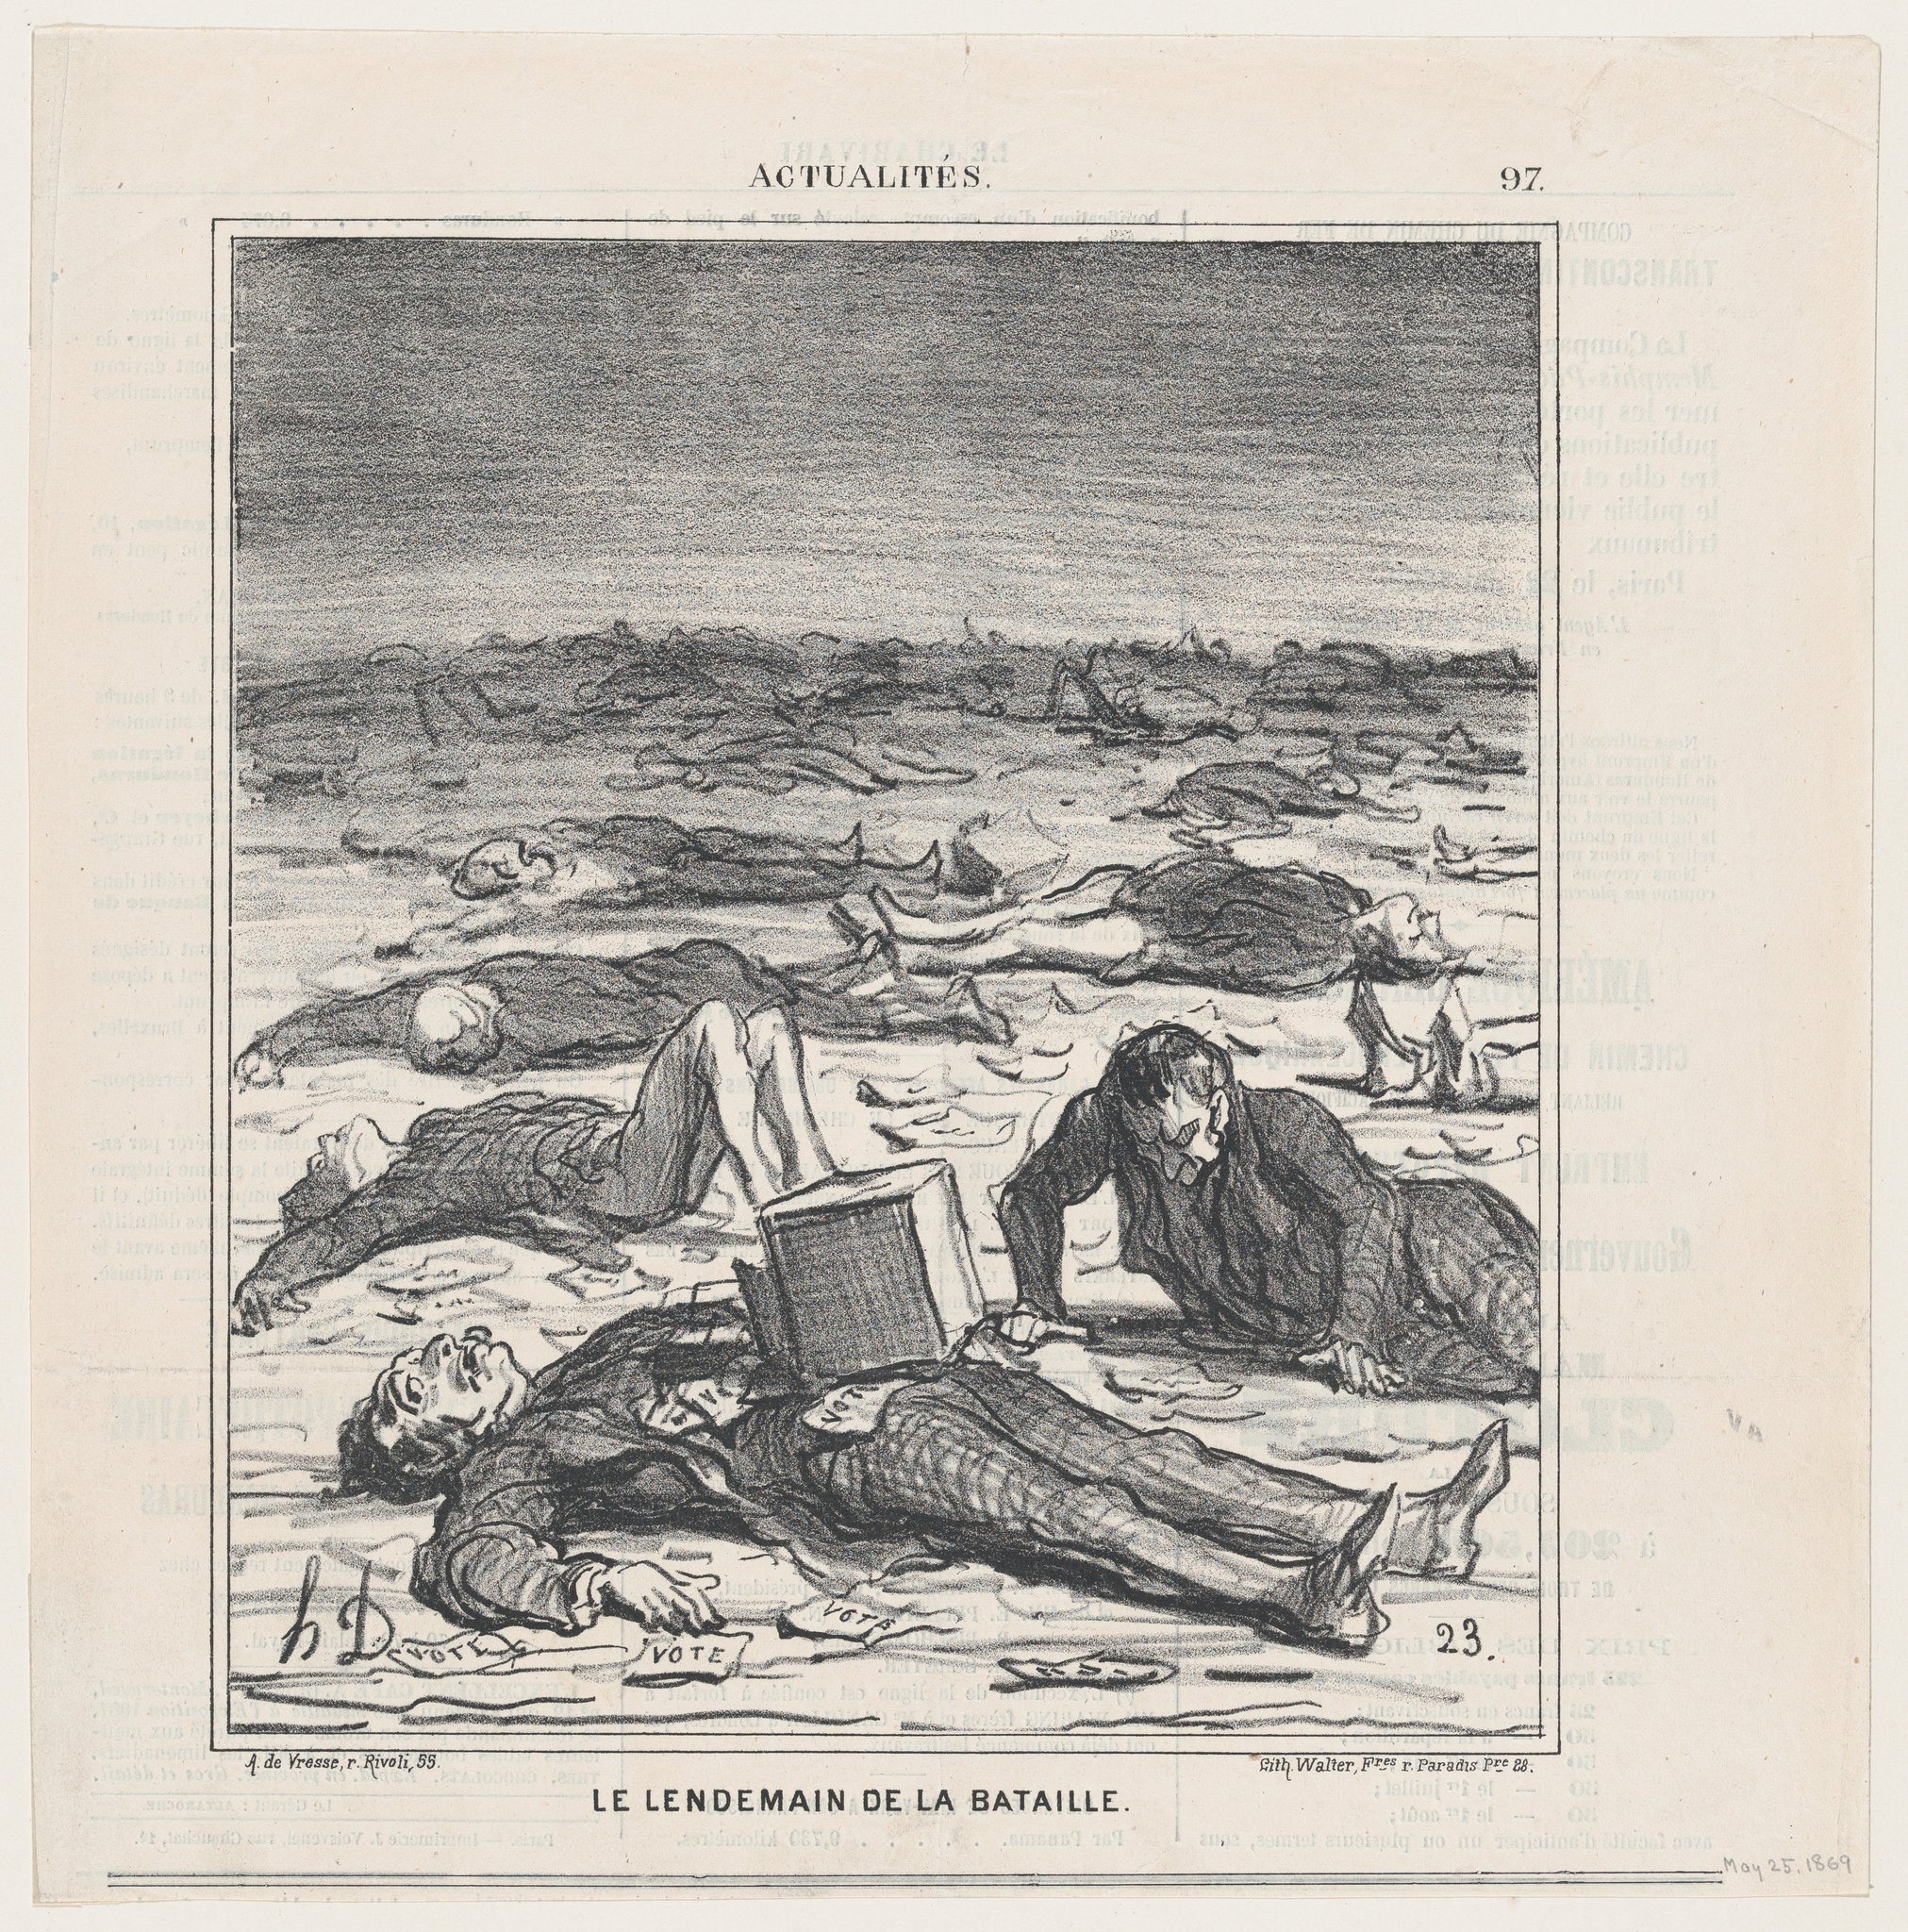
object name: print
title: The day after the battle, from 'News of the day,' published in Le Charivari, May 25, 1869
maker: honoré daumier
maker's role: artist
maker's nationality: french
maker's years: 1808-1879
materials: paper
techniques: lithograph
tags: corpses,men,death